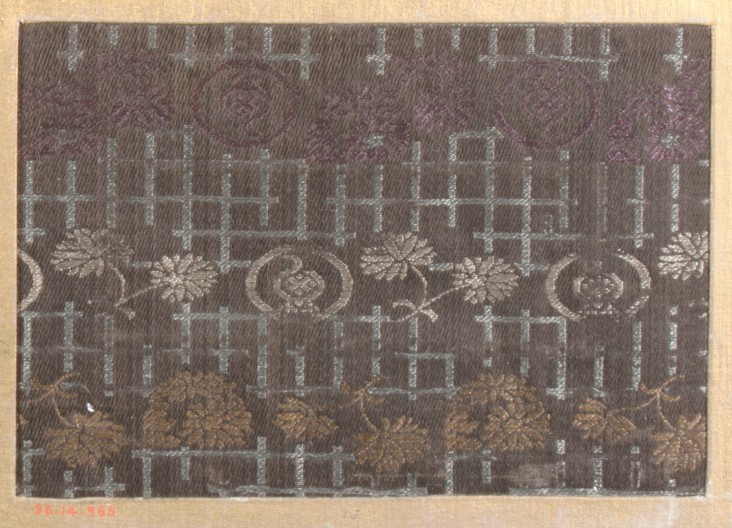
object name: piece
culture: japanese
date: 1701-1900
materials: silk